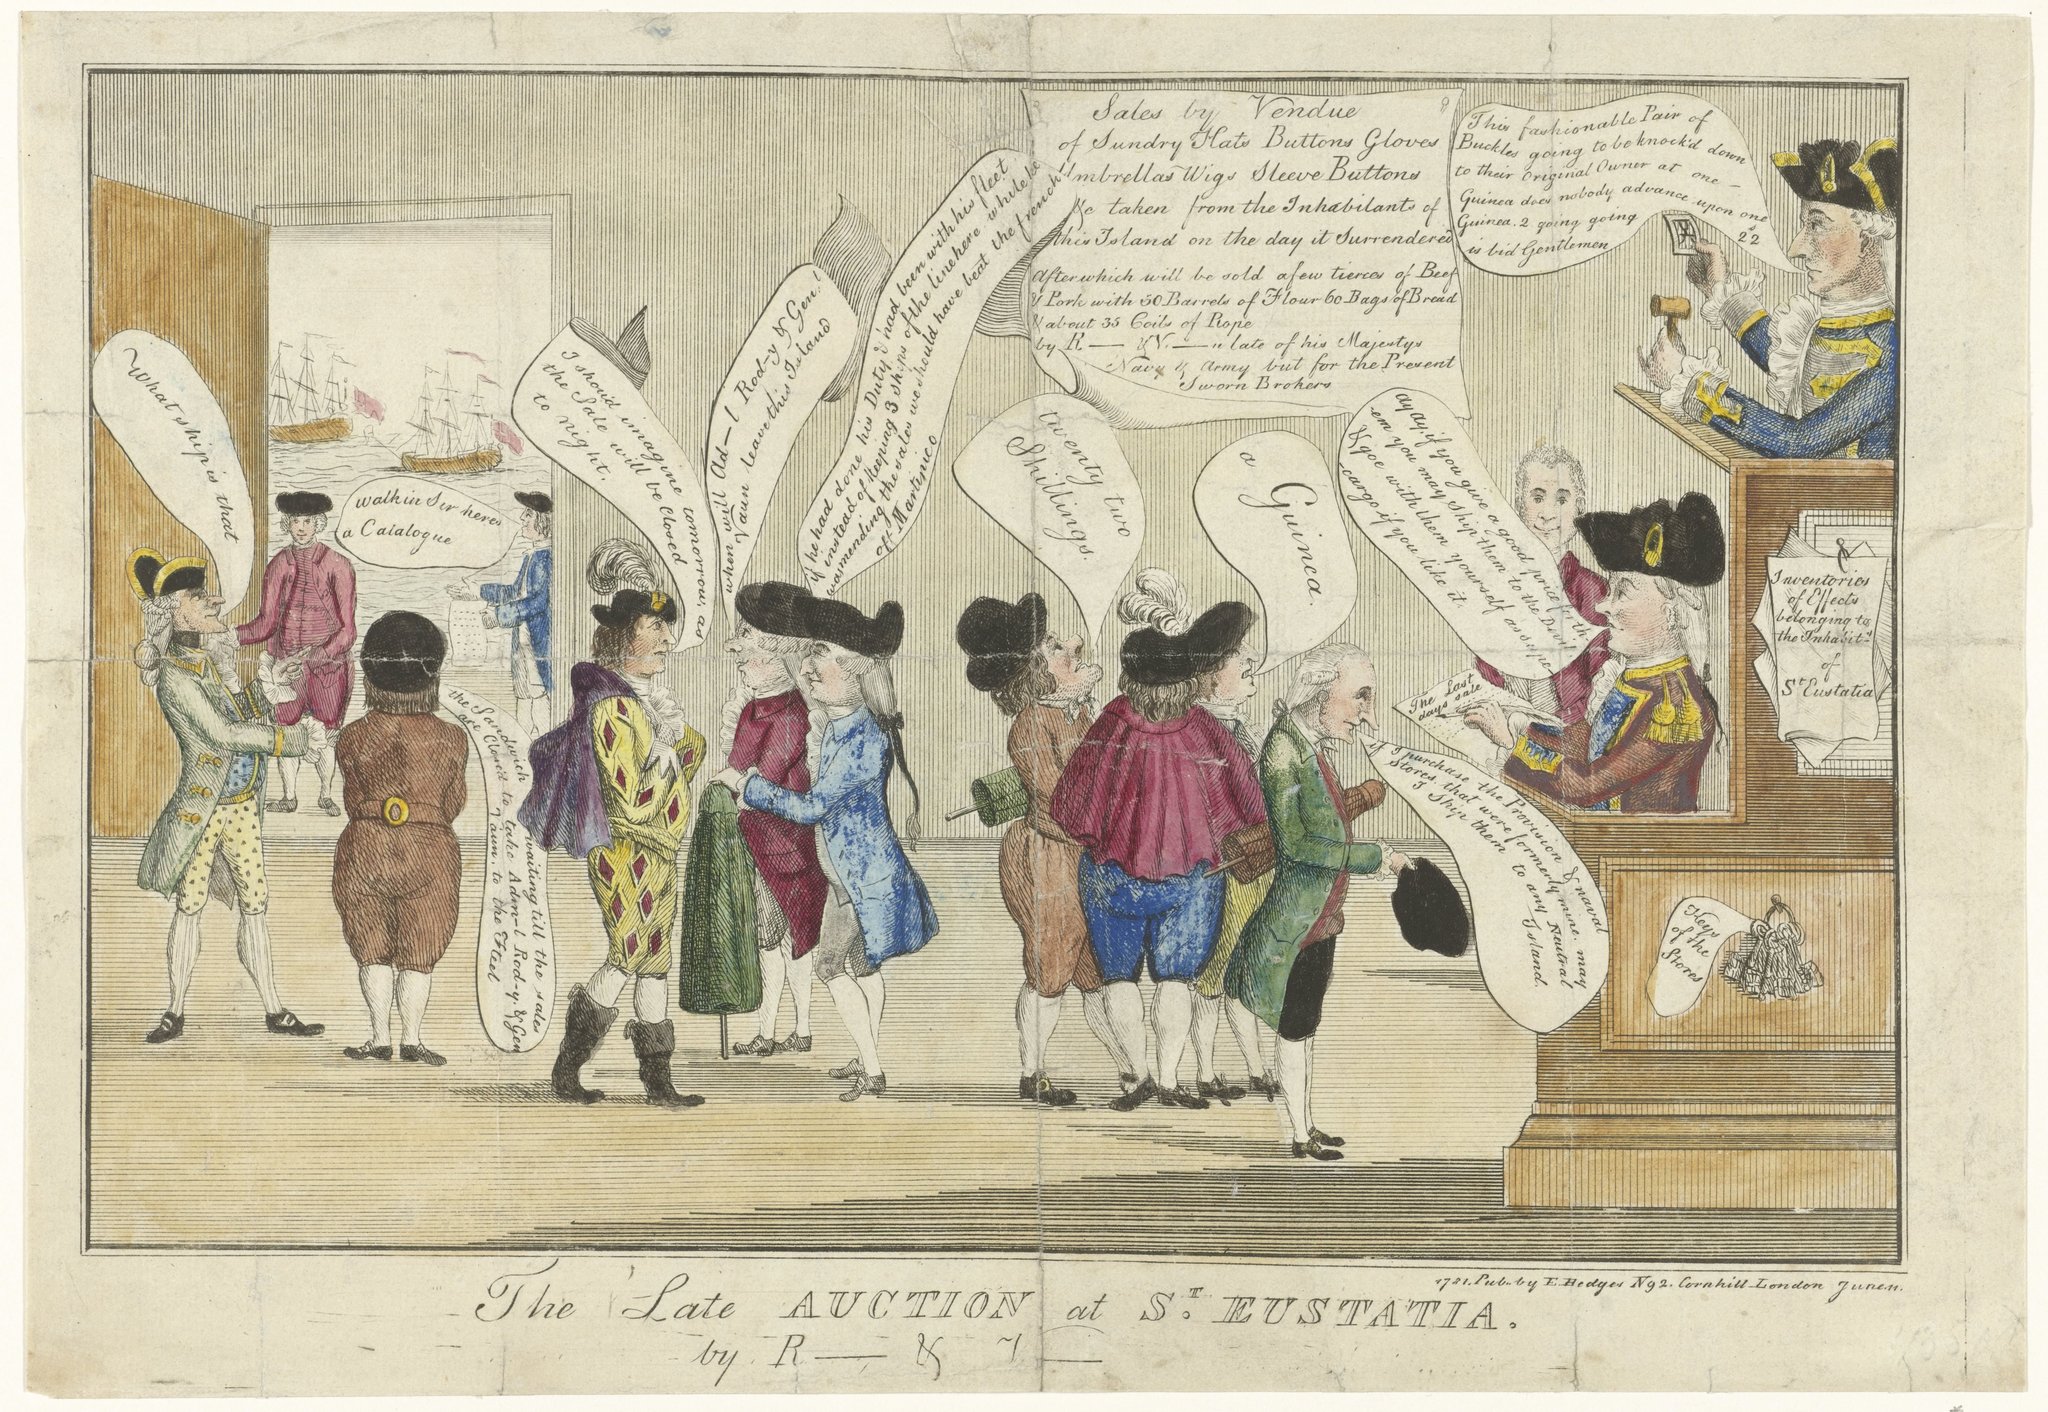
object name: print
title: The Late Auction at St. Eustatia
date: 1781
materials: paper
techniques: etching, hand coloring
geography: london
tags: auction sale, public sale, fourth anglo-dutch war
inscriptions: collector's mark: Lugt 2228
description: Spotprent op de verovering en plundering van he eiland Sint-Eustatia door de Engelsen onder admiraal George Brydges Rodney, 1st Baron Rodney en generaal Sir John Vaughan in 1781 tijdens de Vierde Engels-Nederlandse oorlog. Interieur van een veilinghuis waar de bezittingen van het door de Engelsen geplunderde eiland geveild worden door Rodney en Vaughan. Onder de kopers behalve Engelsen ook een Nederlander en een Fransman.